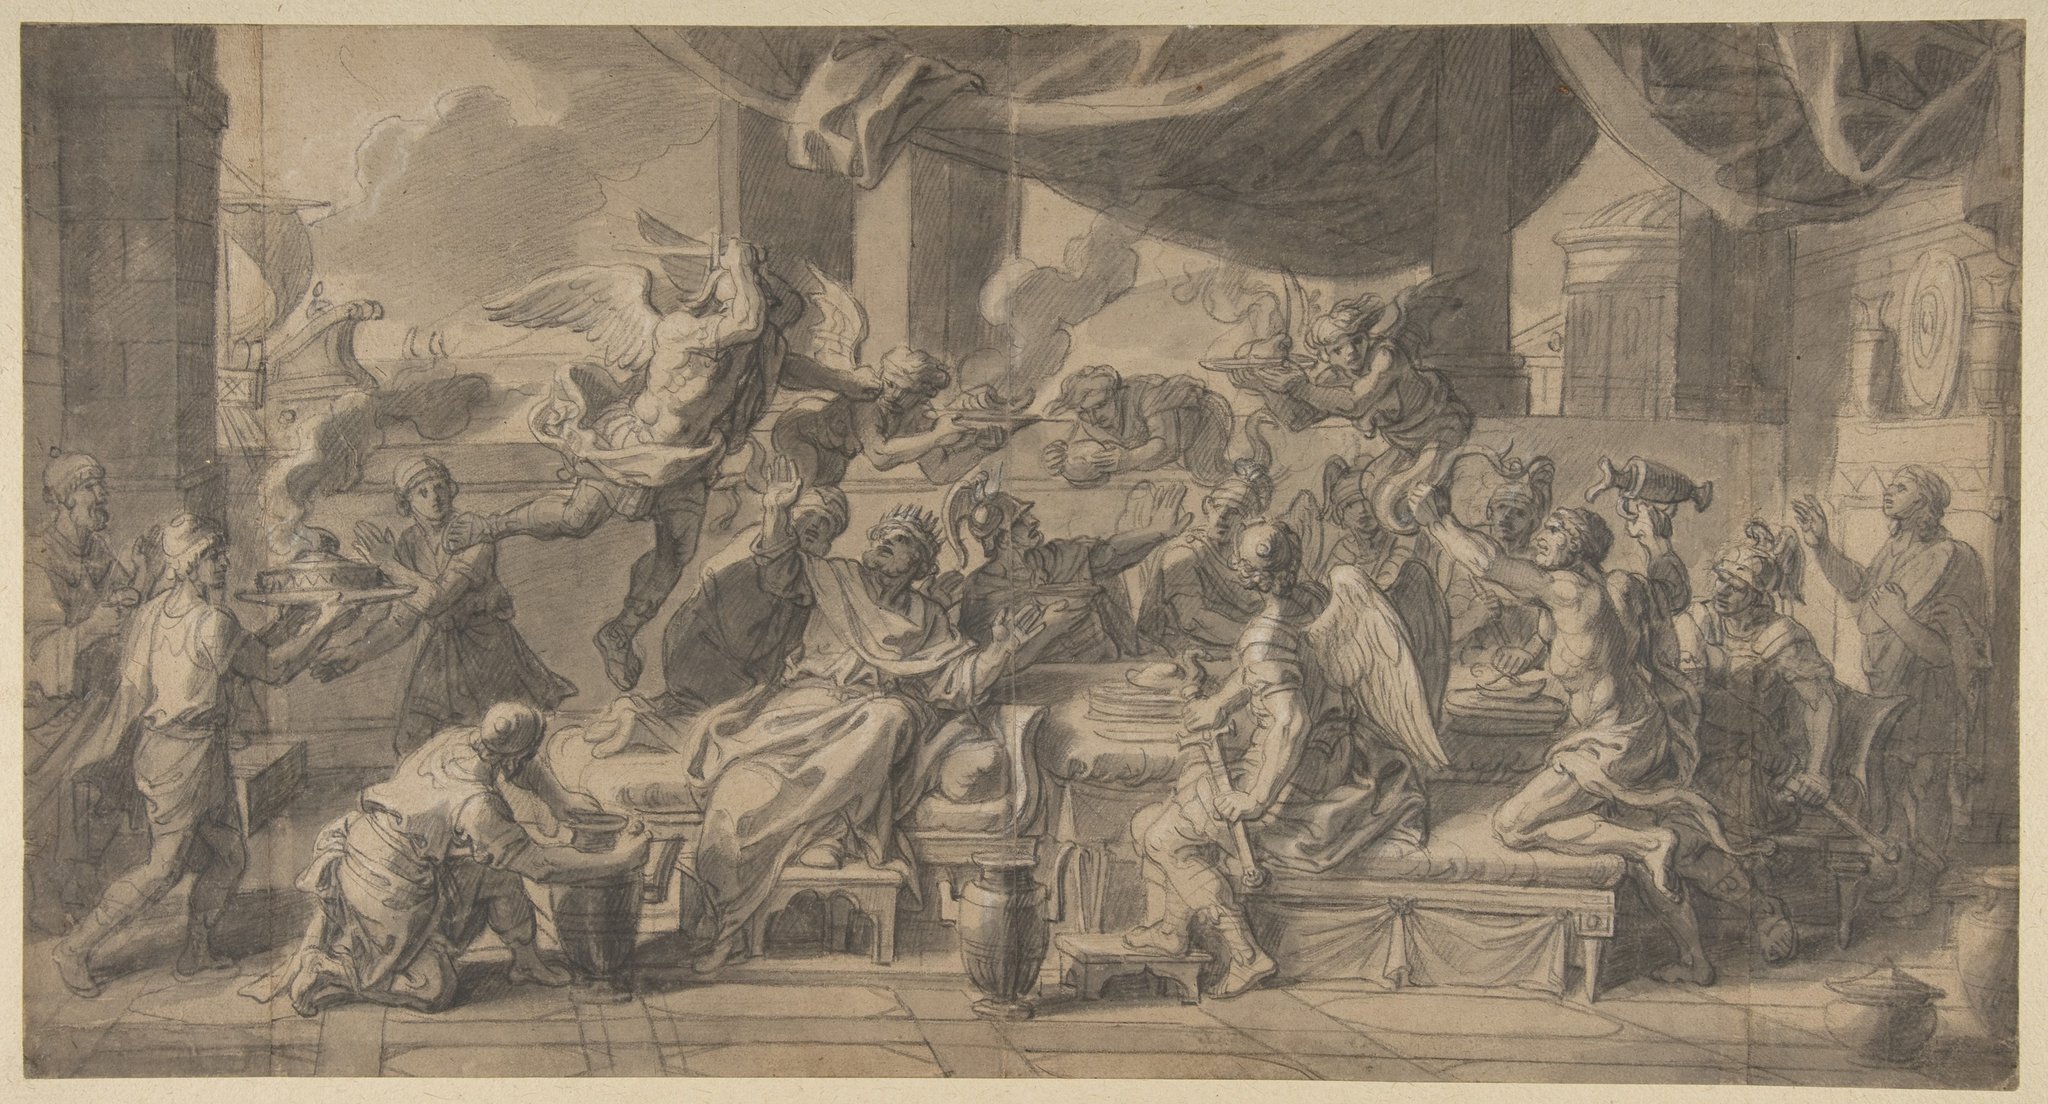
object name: drawing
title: The Harpies Driven from the Table of King Phineus by Zetes and Calais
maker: françois verdier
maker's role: artist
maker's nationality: french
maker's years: 1651-1730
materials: chalk, paper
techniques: brush, heightening, wash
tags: men